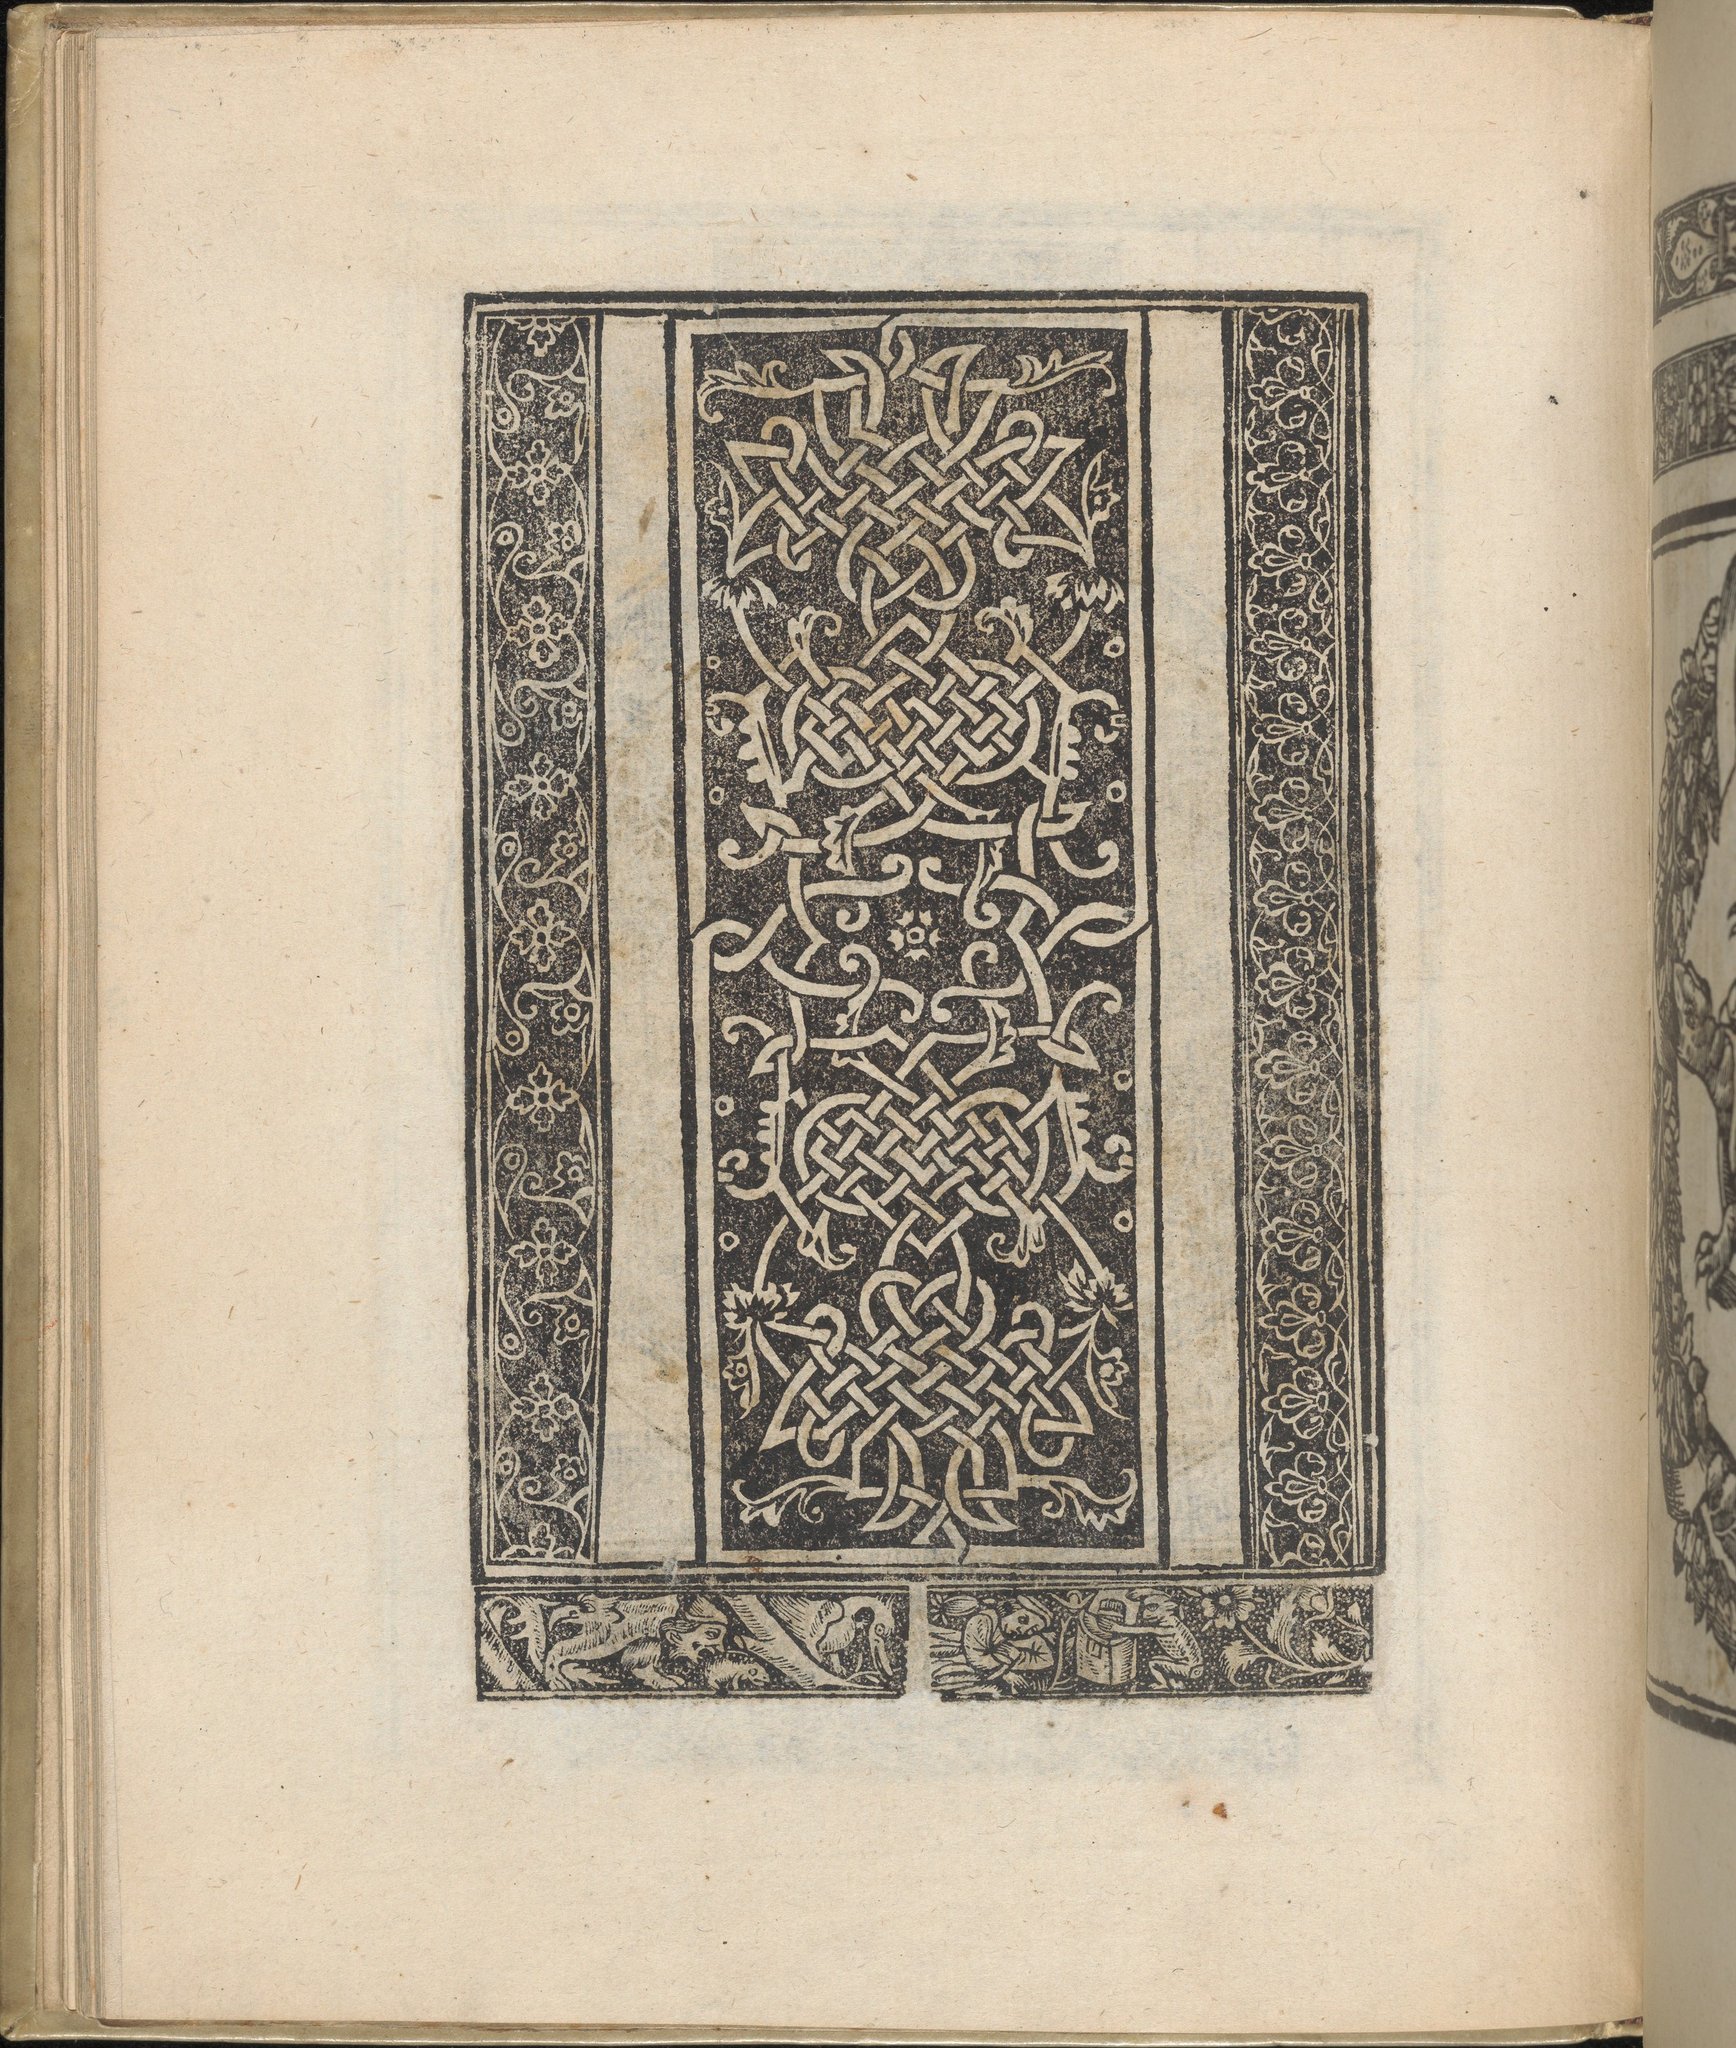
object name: book print ornament architecture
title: Trionfo Di Virtu. Libro Novo..., page 21 (recto)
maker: matteo pagano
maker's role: publisher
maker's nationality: italian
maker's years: 1515-1588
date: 1563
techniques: woodcut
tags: ornament